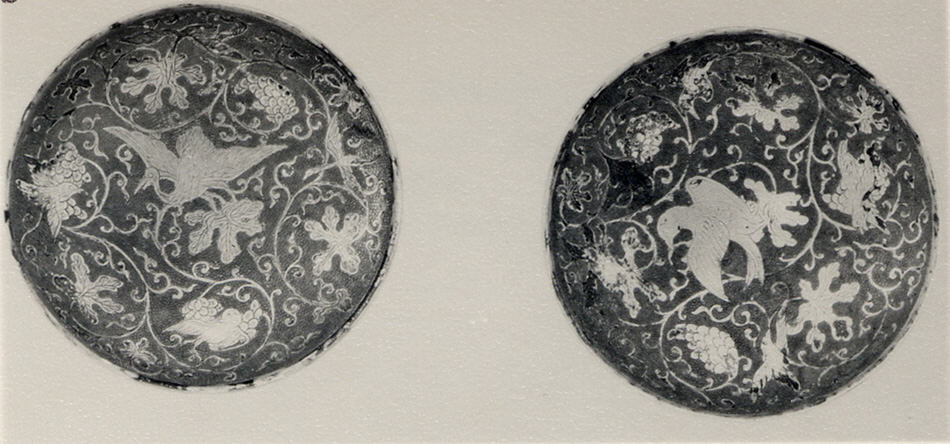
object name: box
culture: chinese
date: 701-800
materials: silver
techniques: gilding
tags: birds,flowers